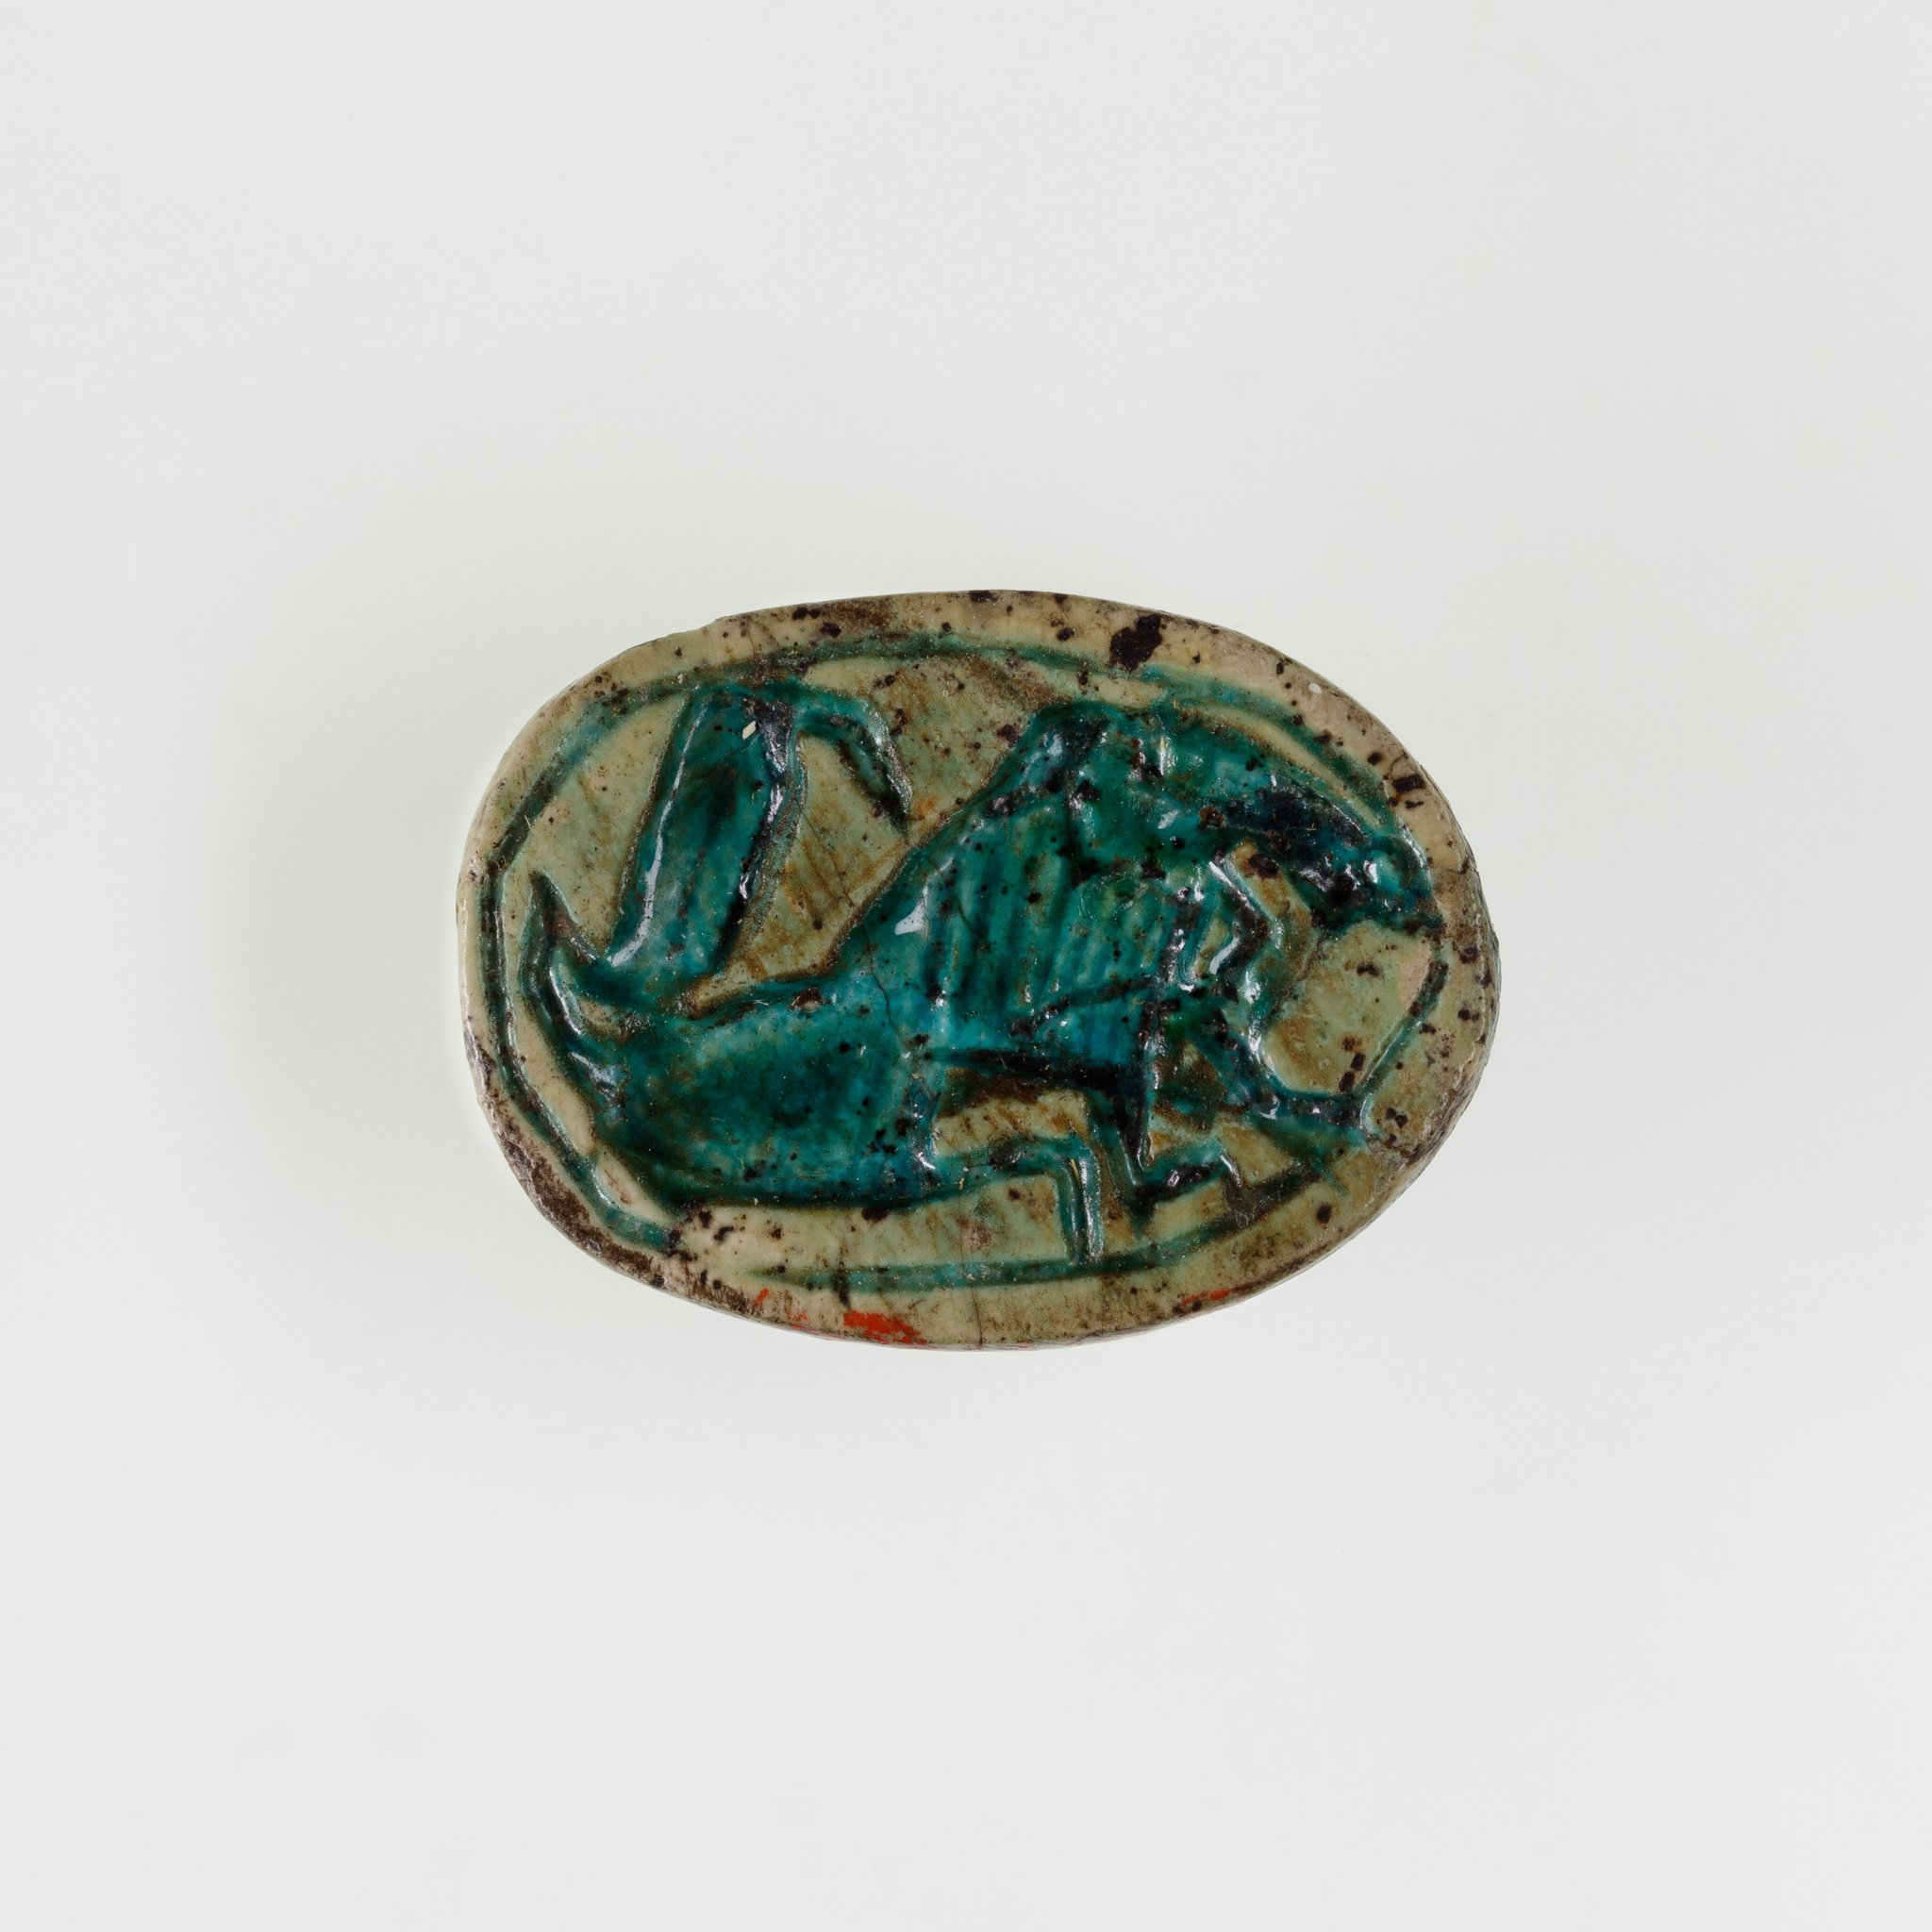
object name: scarab, animal, lion, uraeus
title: Scarab with Lion and Uraeus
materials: stone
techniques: glazing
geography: egypt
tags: scarabs